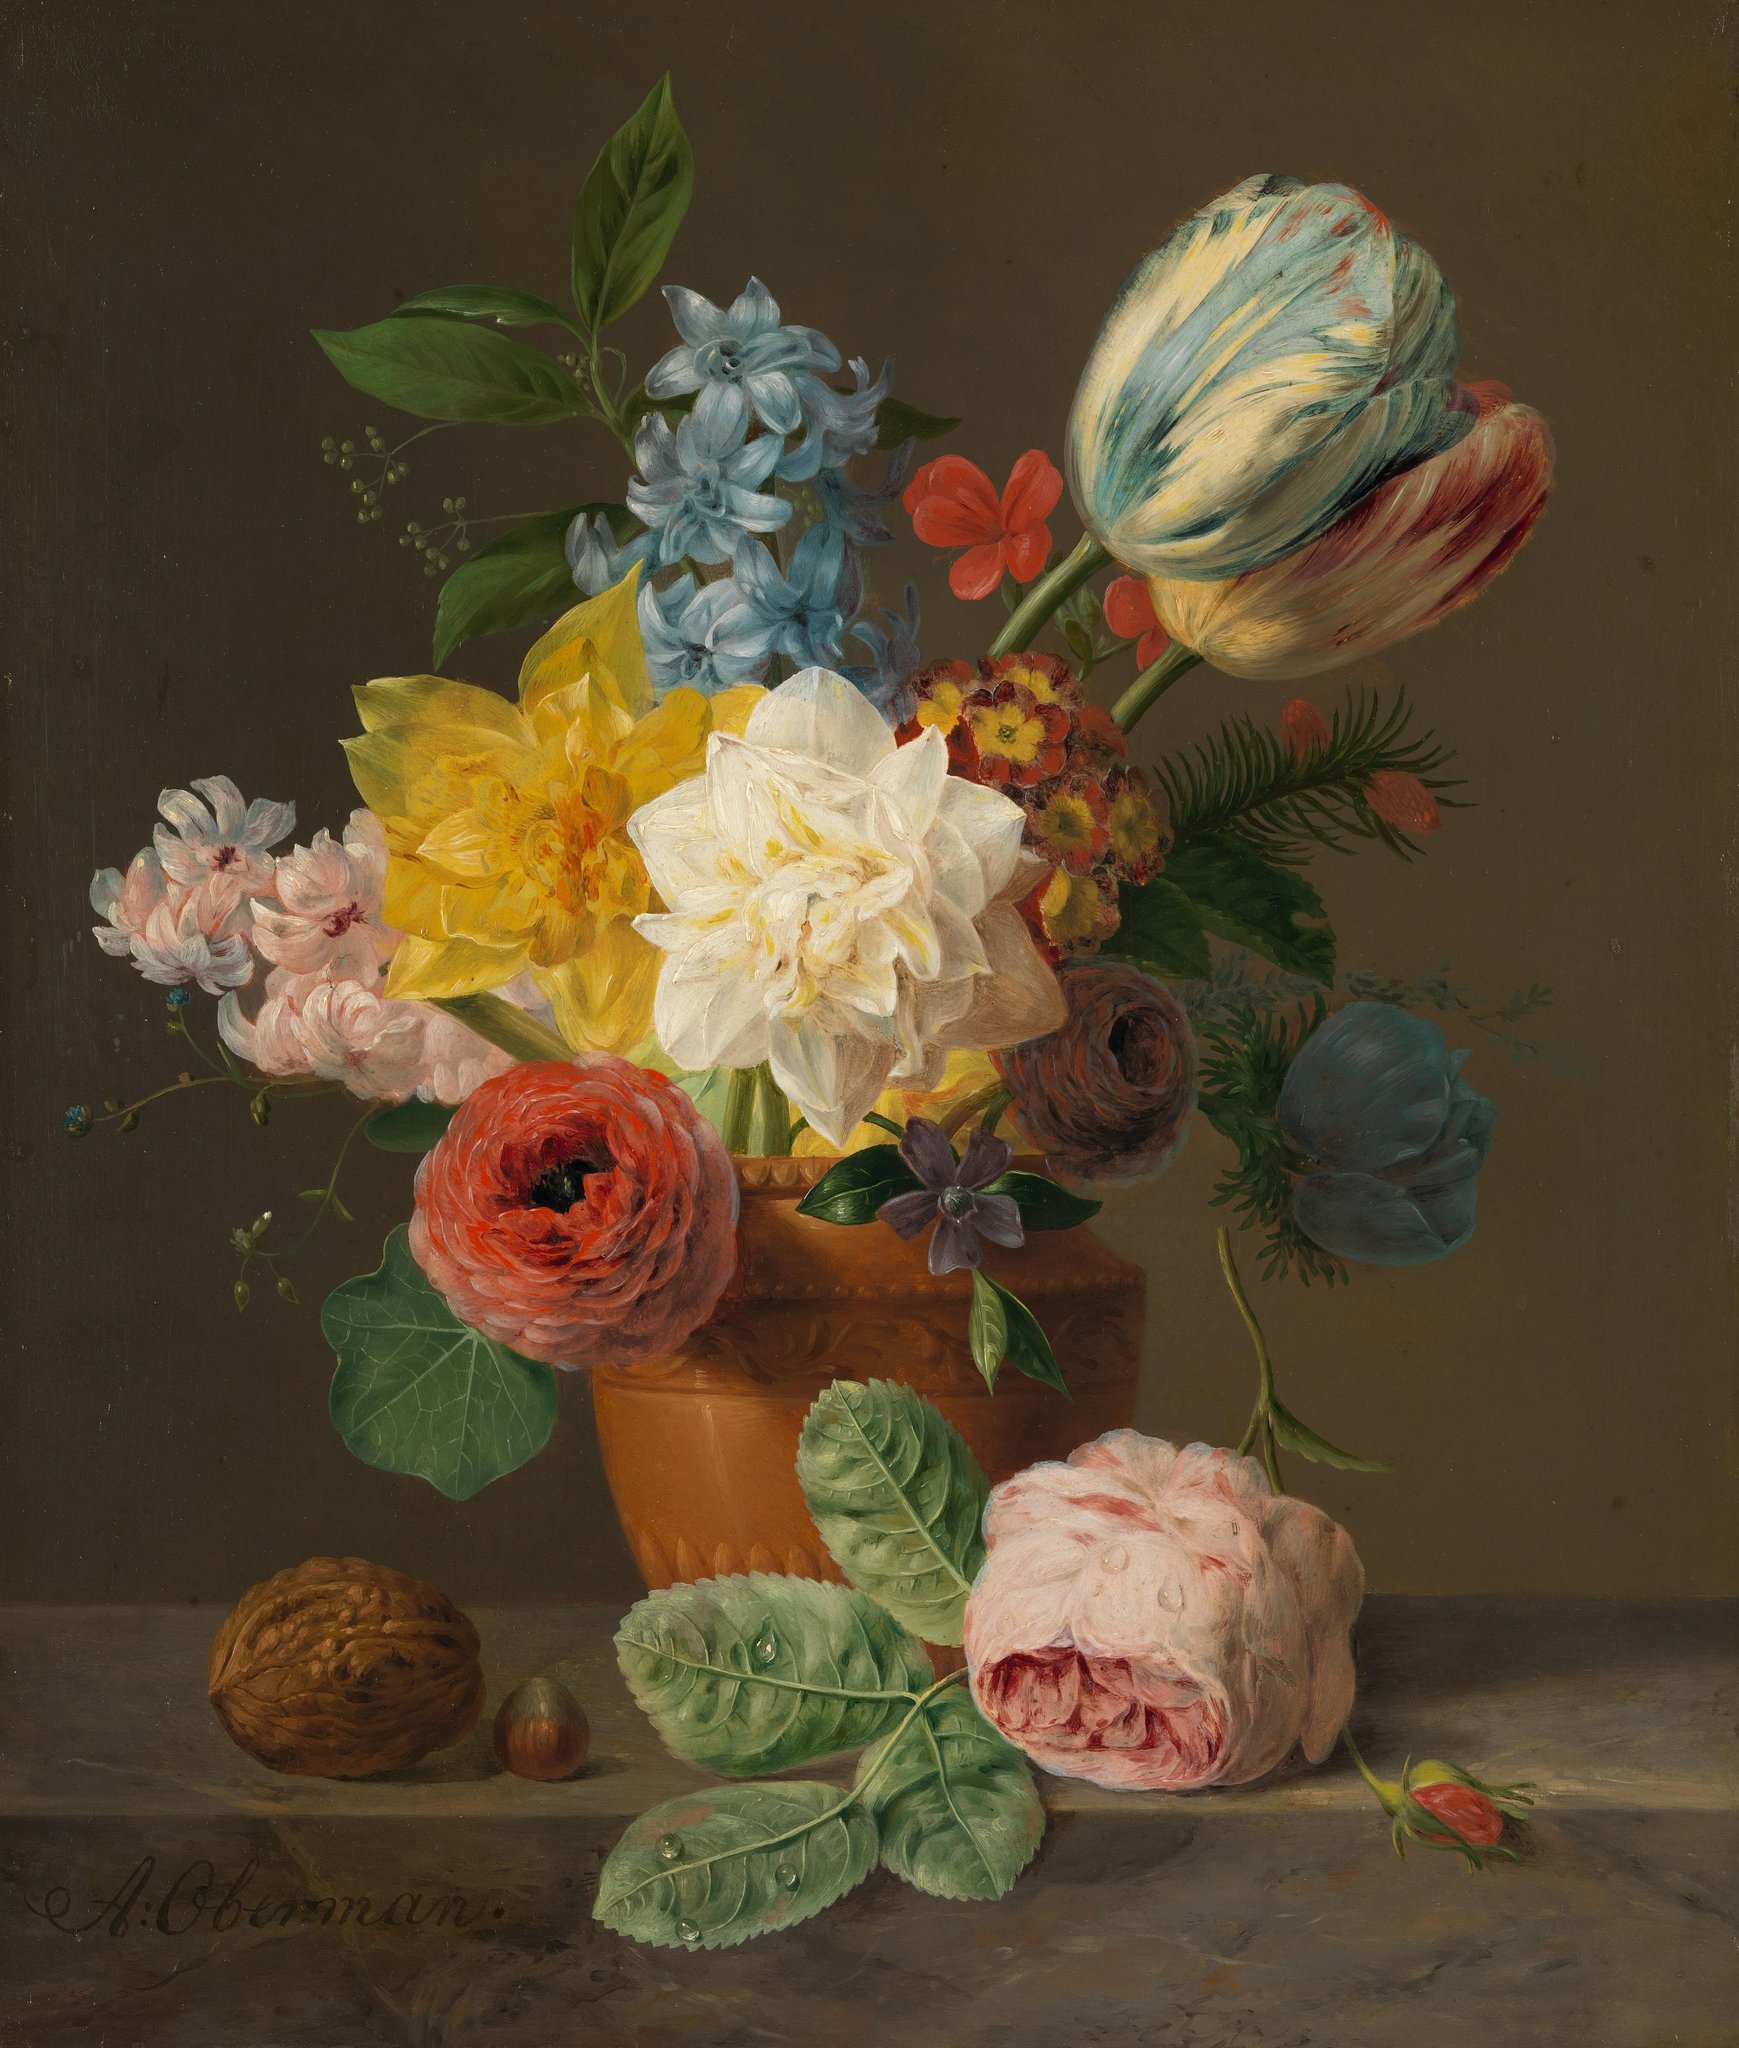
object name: painting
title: Still Life with Flowers and Nuts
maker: anthony oberman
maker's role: draughtsman, painter, print maker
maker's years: 1781-1845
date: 1830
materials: cardboard, oil, paint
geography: amsterdam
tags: flowers, still life of related objects, flowers in a vase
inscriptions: number: ‘No 2’, inscription: ‘over de glazen regts’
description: Floral still lifes of the Romantic period are characterised by their simple composition, light colour and the profusion of native species. So too in this still life: we see authentic Dutch plants such as primulas, geraniums, periwinkles, forget-me-nots and nasturtiums, as well as plants that were cultivated in glasshouses around 1830: daffodils, anemones, tulips and hyacinths. The blue tulip was originally purple: remains of the lost red pigment are still visible.